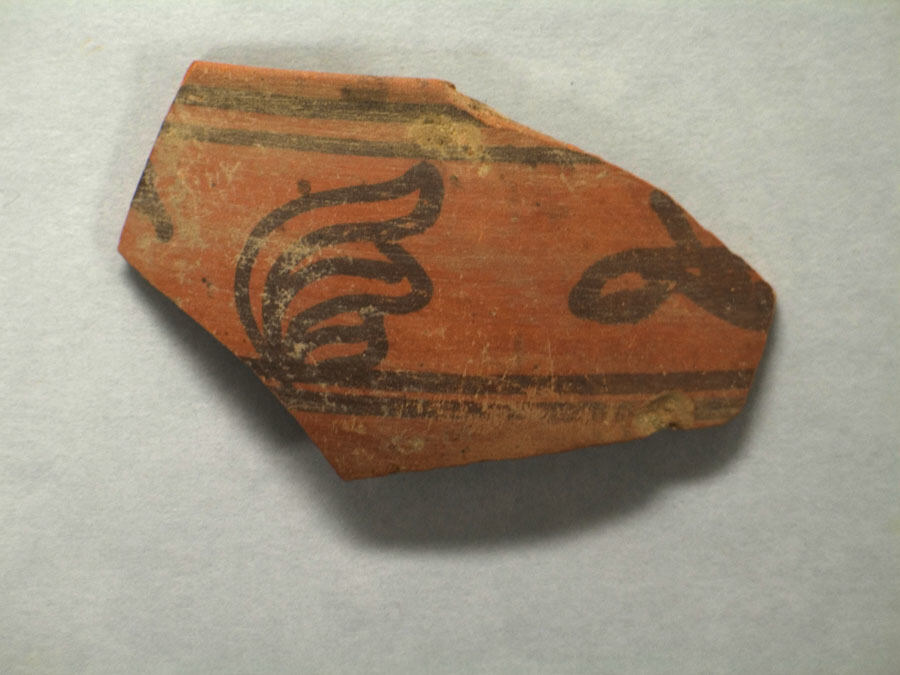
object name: shard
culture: pakistani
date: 301-500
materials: terracotta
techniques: painting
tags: gandhara